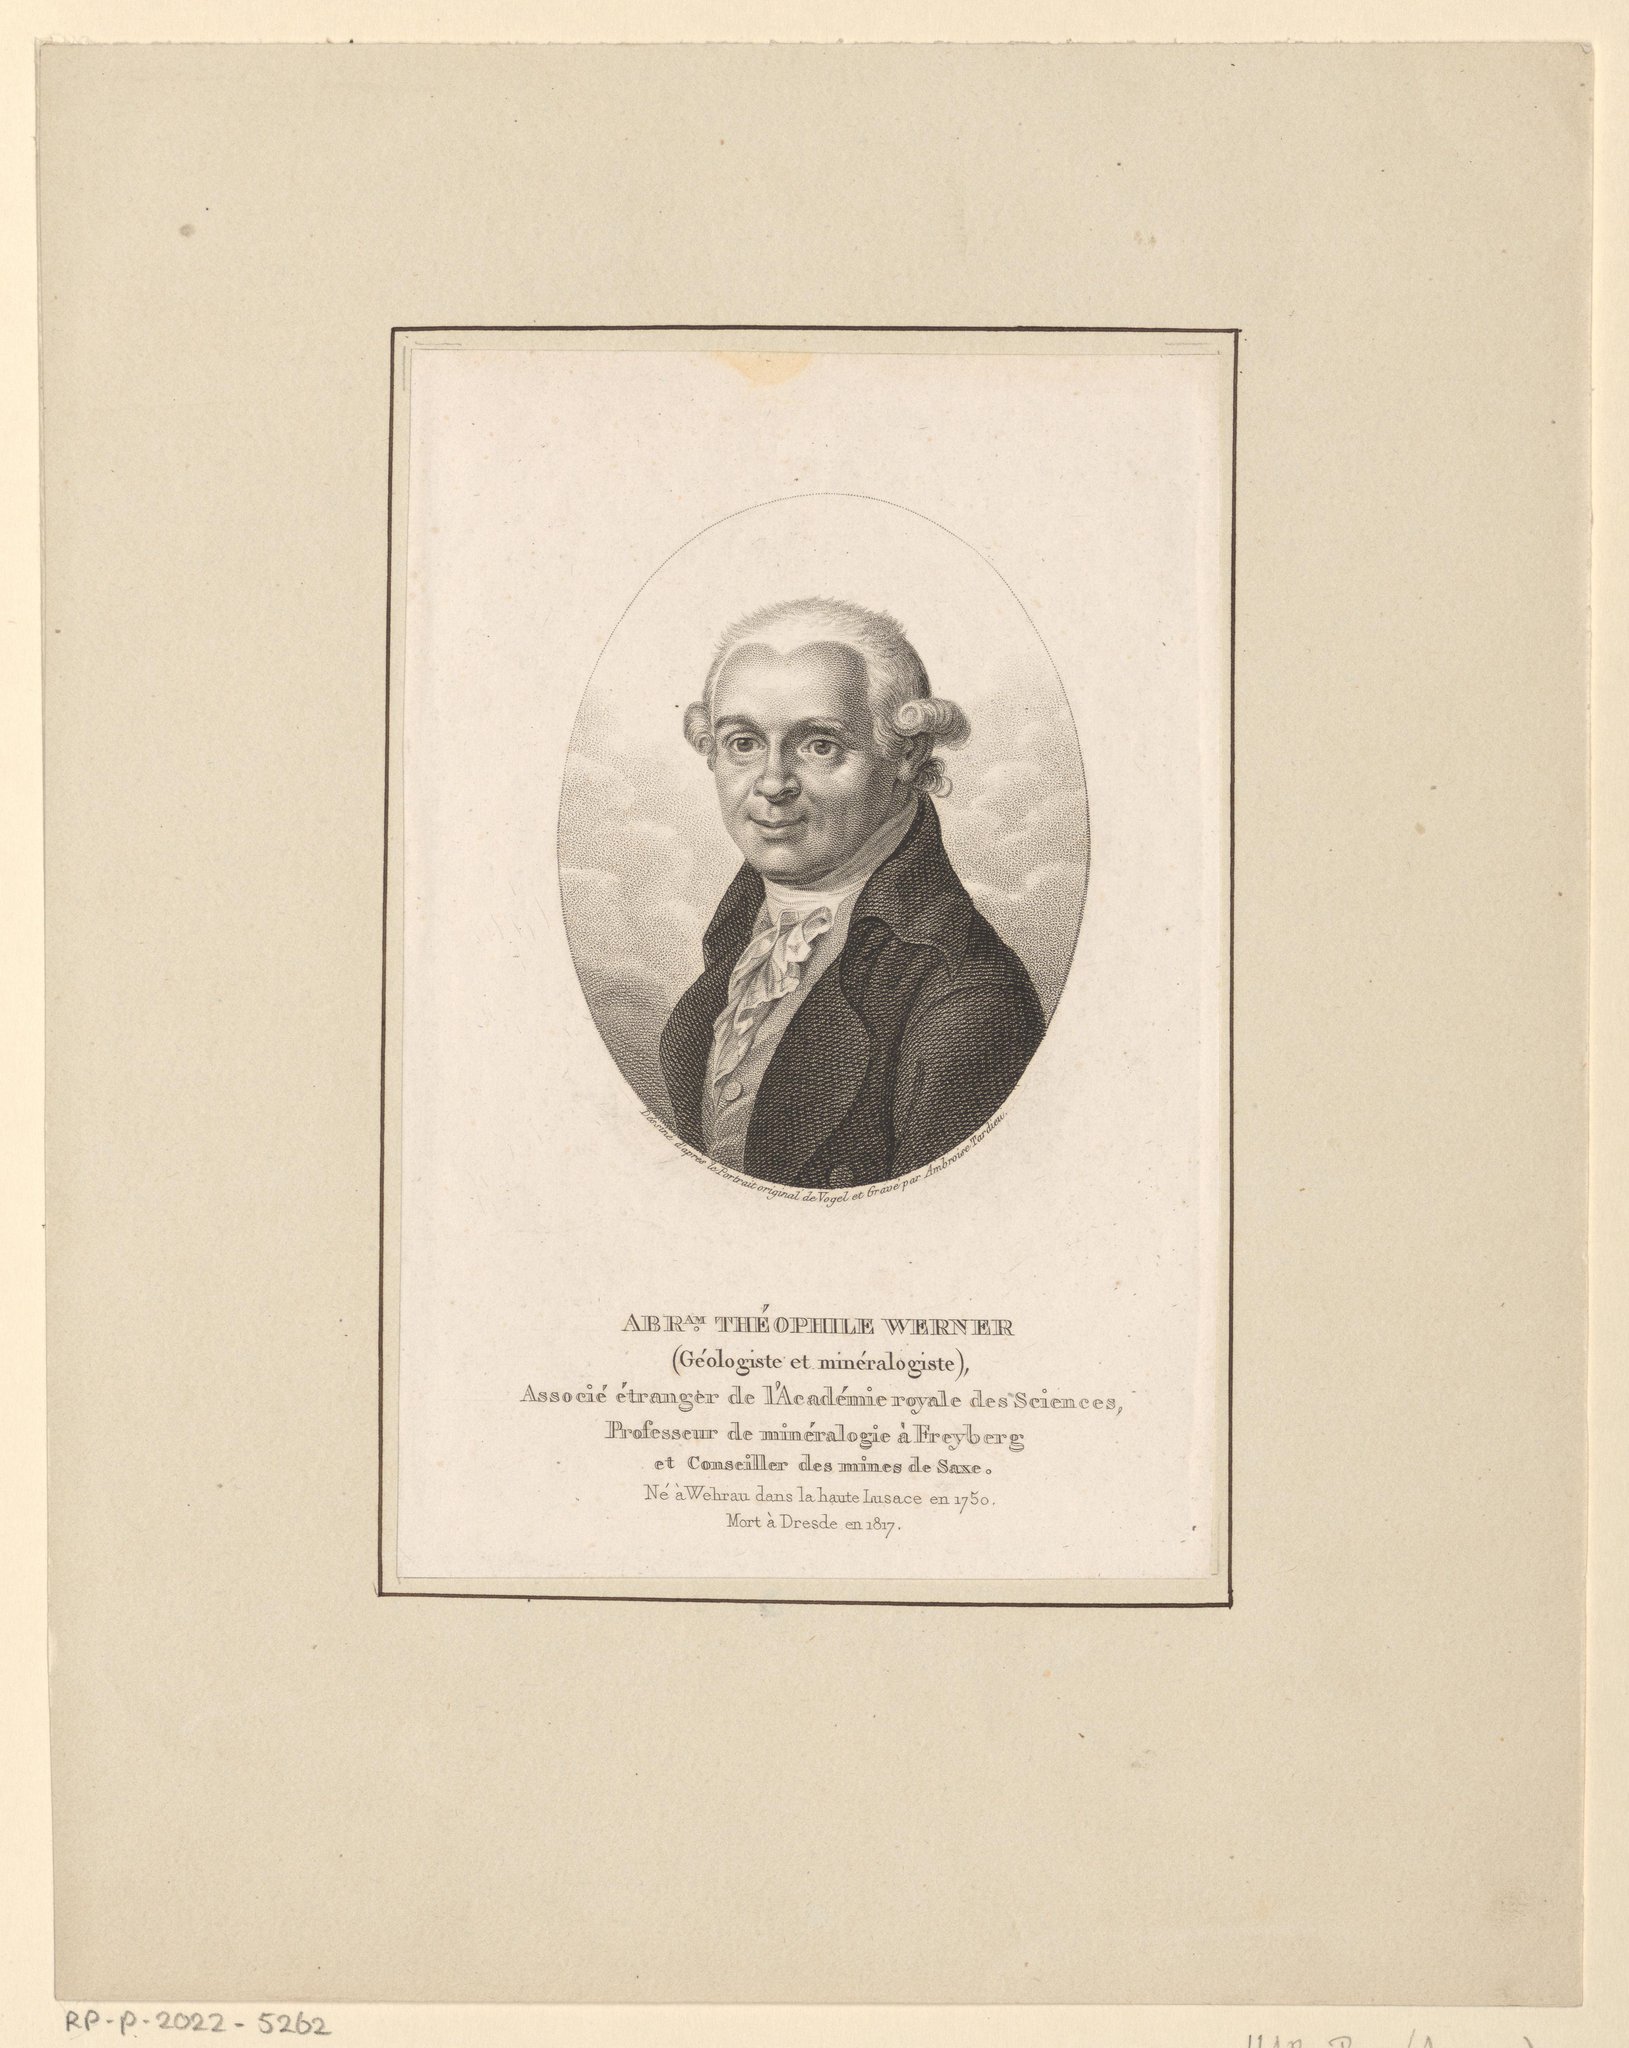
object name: print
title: Portret van Abraham Gottlob Werner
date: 1817-1841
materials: paper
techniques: engraving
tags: historical persons, professor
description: Met zesregelig onderschrift in het Frans.